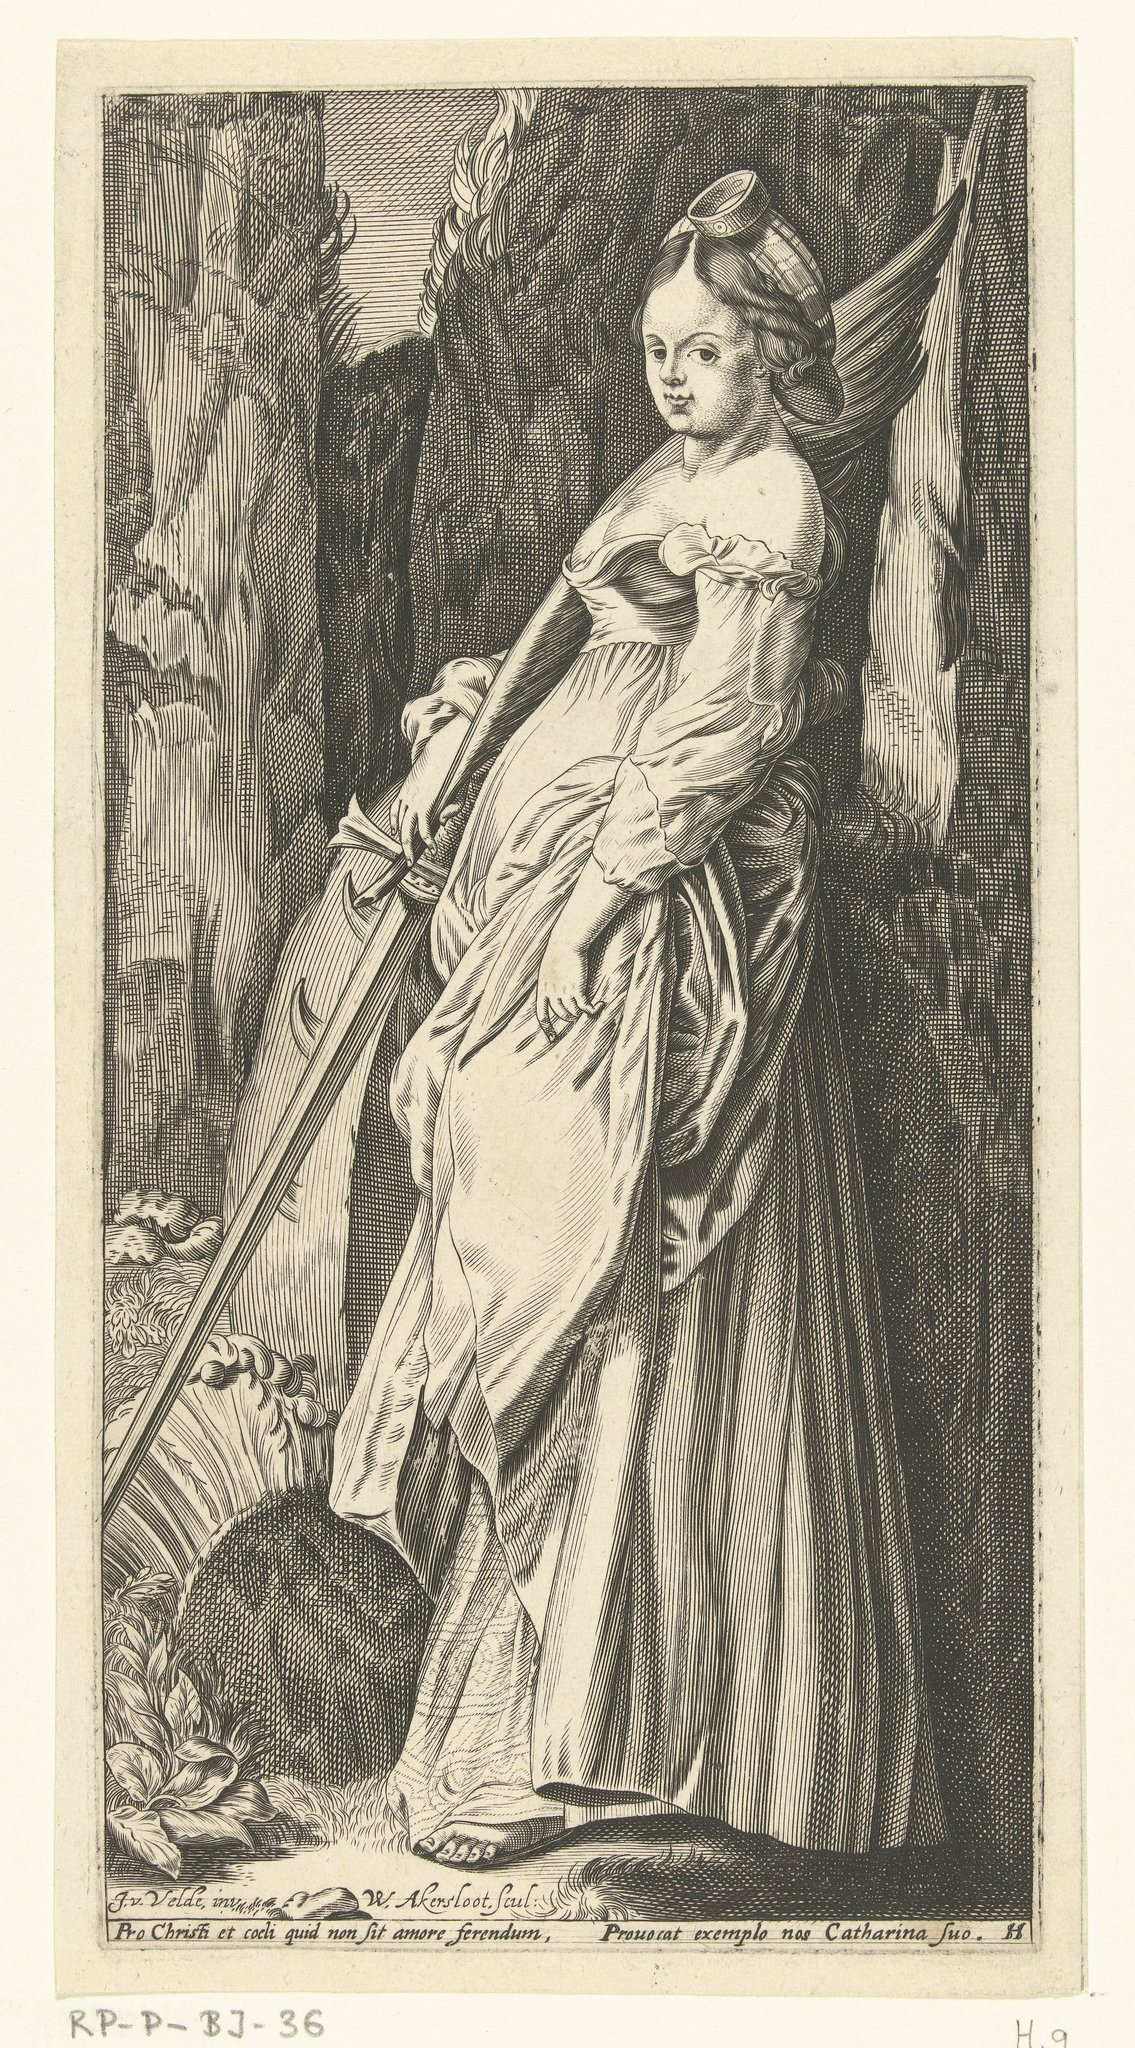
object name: print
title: De heilige Catharina van Alexandrië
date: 1610-1651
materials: paper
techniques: engraving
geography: netherlands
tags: the virgin martyr catherine of alexandria; possible attributes: book, crown, emperor maxentius, palm-branch, ring, sword, wheel, ring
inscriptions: collector's mark: Lugt 240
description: De heilige Catharina van Alexandrië ten voeten uit in een rotslandschap voor een rad. In haar hand draagt zij een palmtak en een zwaard. Een haarband met erop een ring siert haar hoofd. Onder de voorstelling een vers in het Latijn, ondertekend met het monogram HSS.